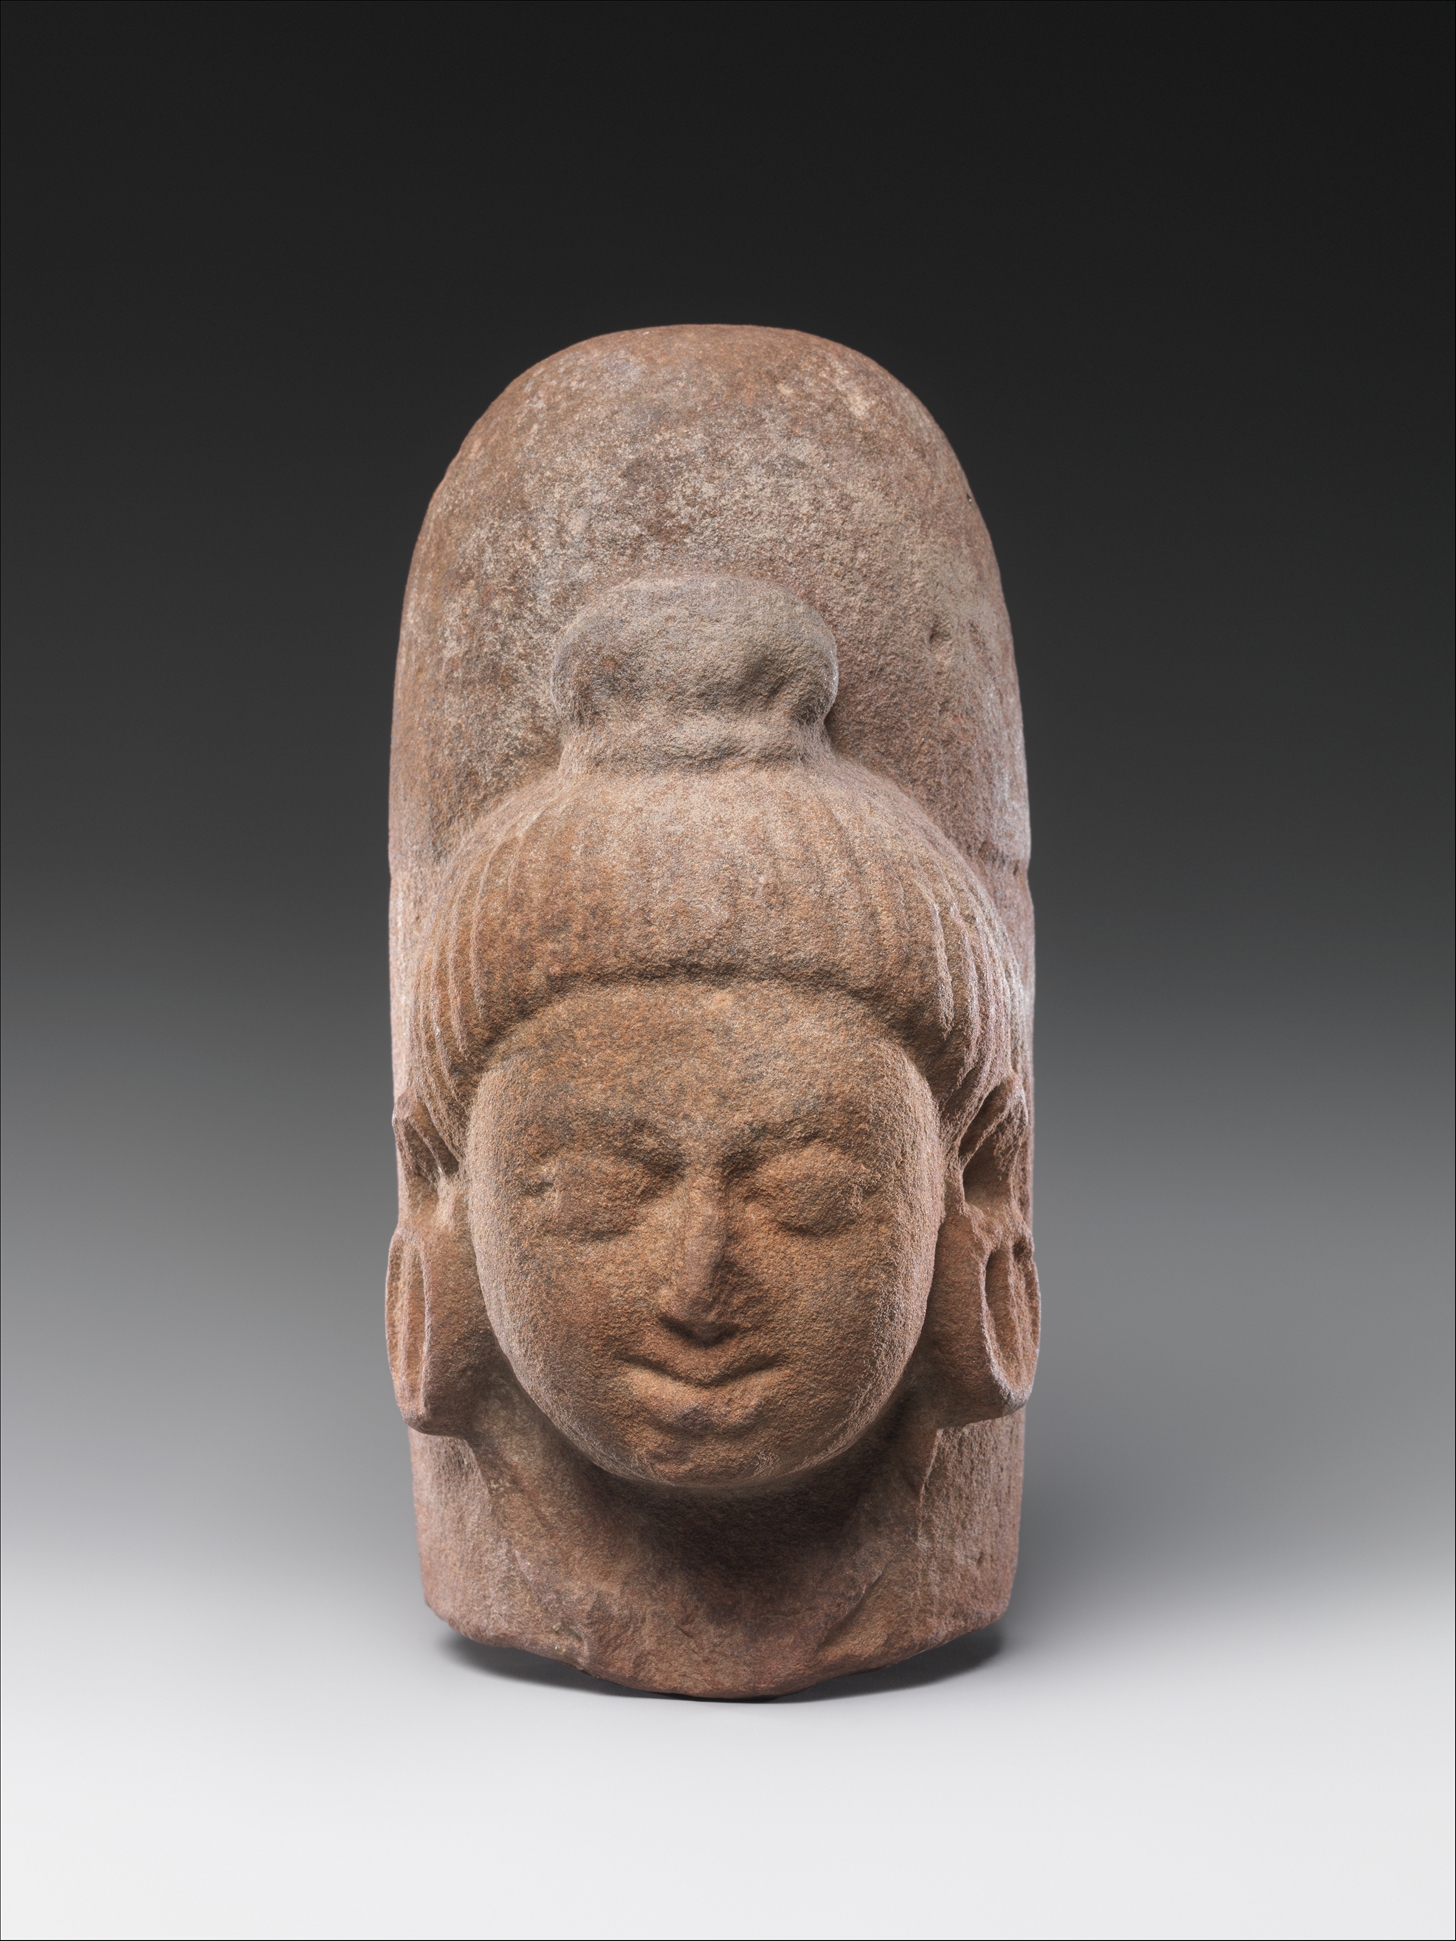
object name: linga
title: Linga with Face of Shiva (Ekamukhalinga)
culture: indian, madhya pradesh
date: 401-450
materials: stone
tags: gupta,shiva,hinduism